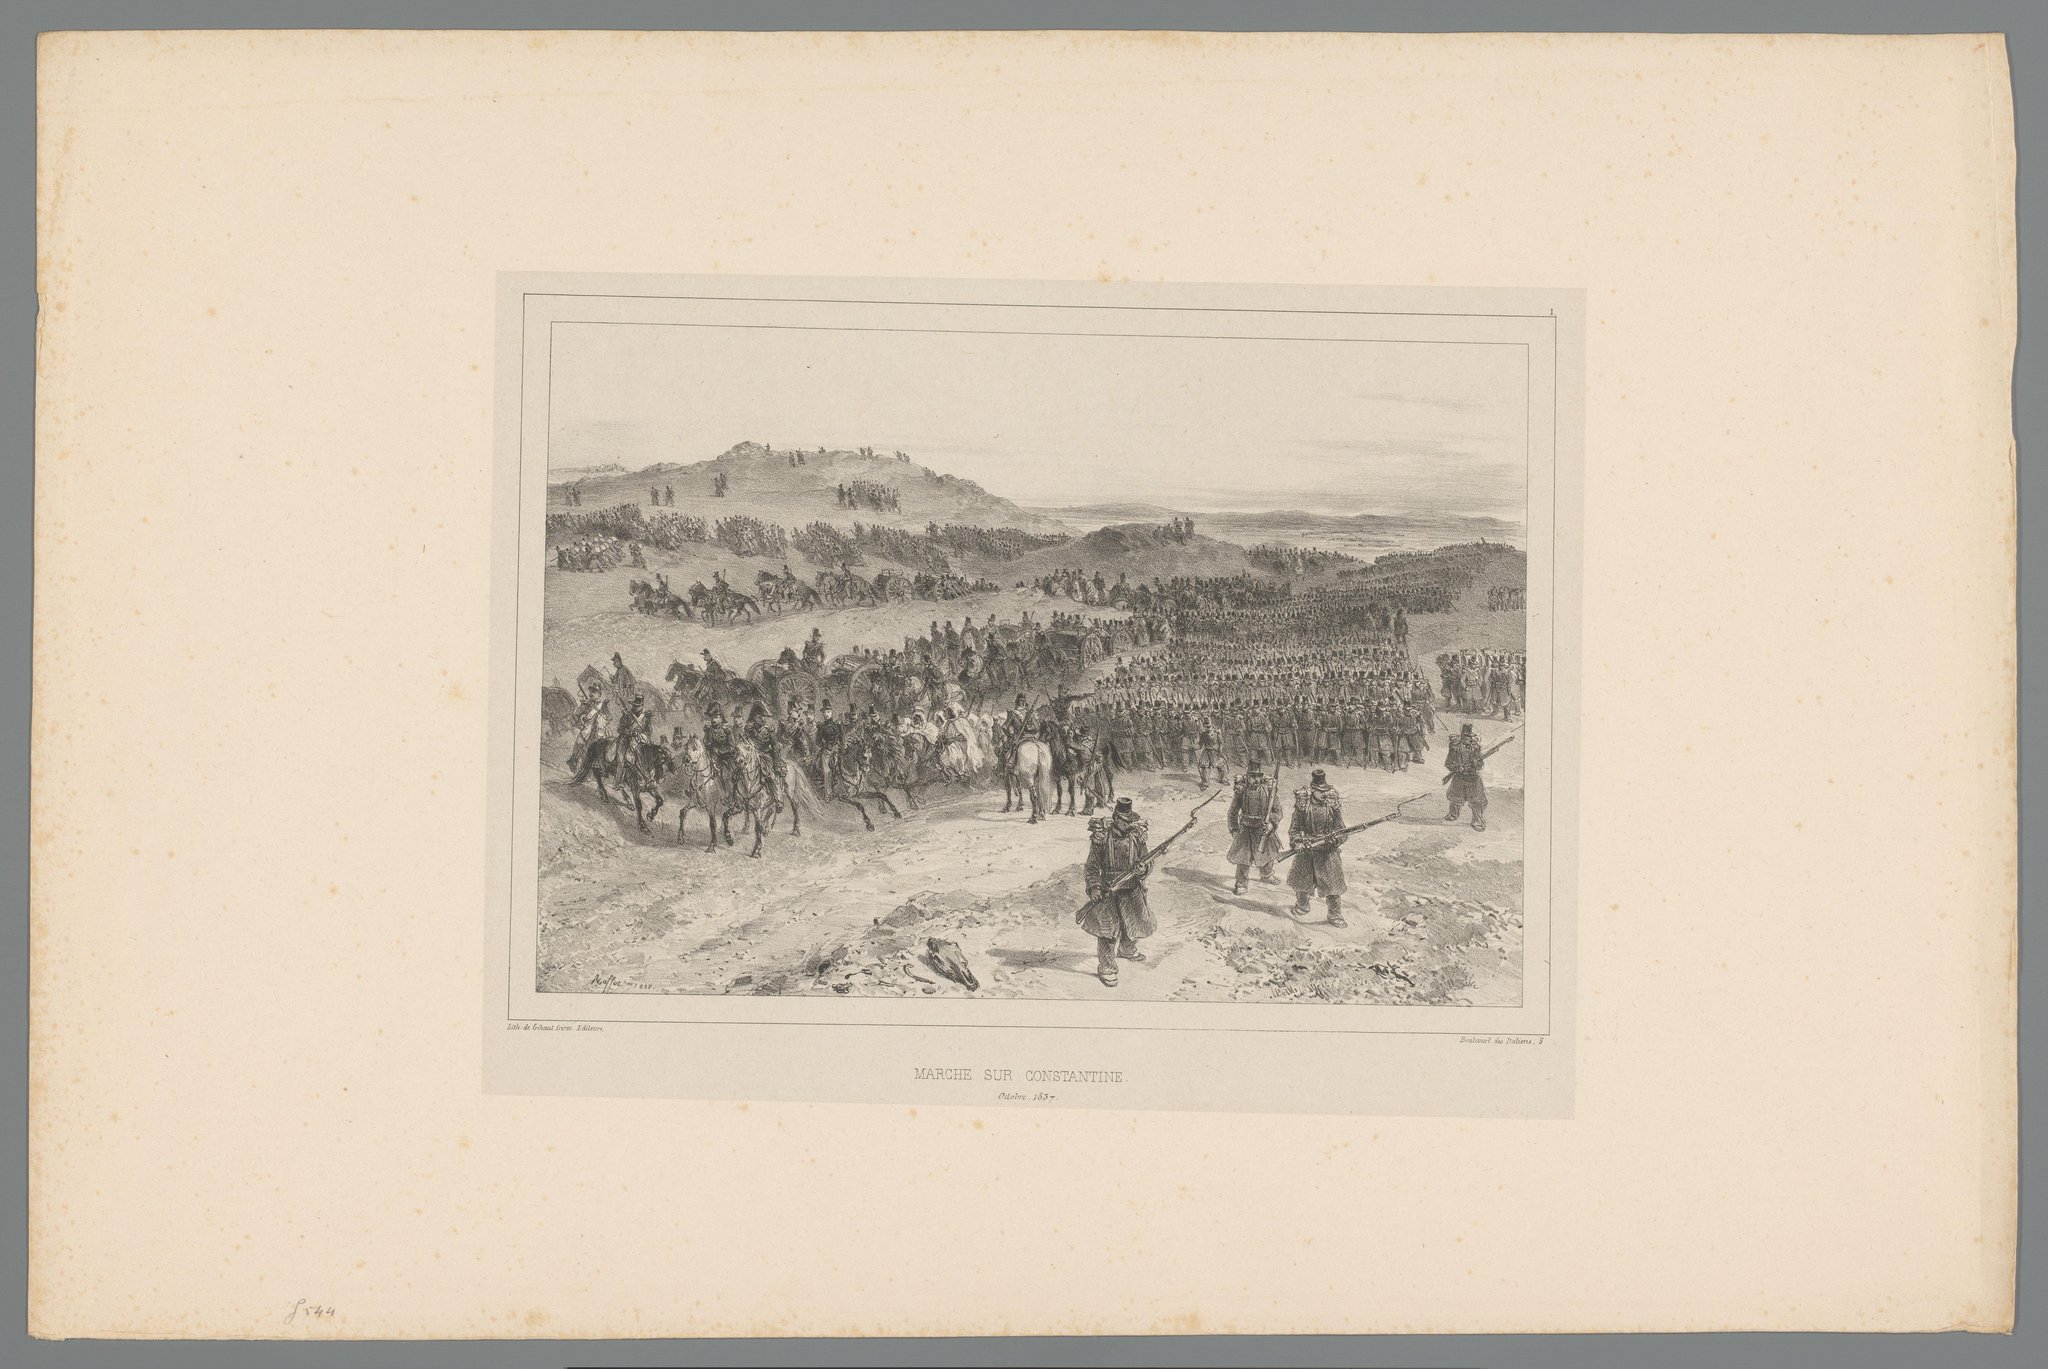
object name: print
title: Inname van Constantine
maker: denis auguste marie raffet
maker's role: draughtsman, print maker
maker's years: 1804-1860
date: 1838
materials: paper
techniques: lithograph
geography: paris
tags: marching away (troops), the soldier; the soldier's life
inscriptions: collector's mark: Lugt 964